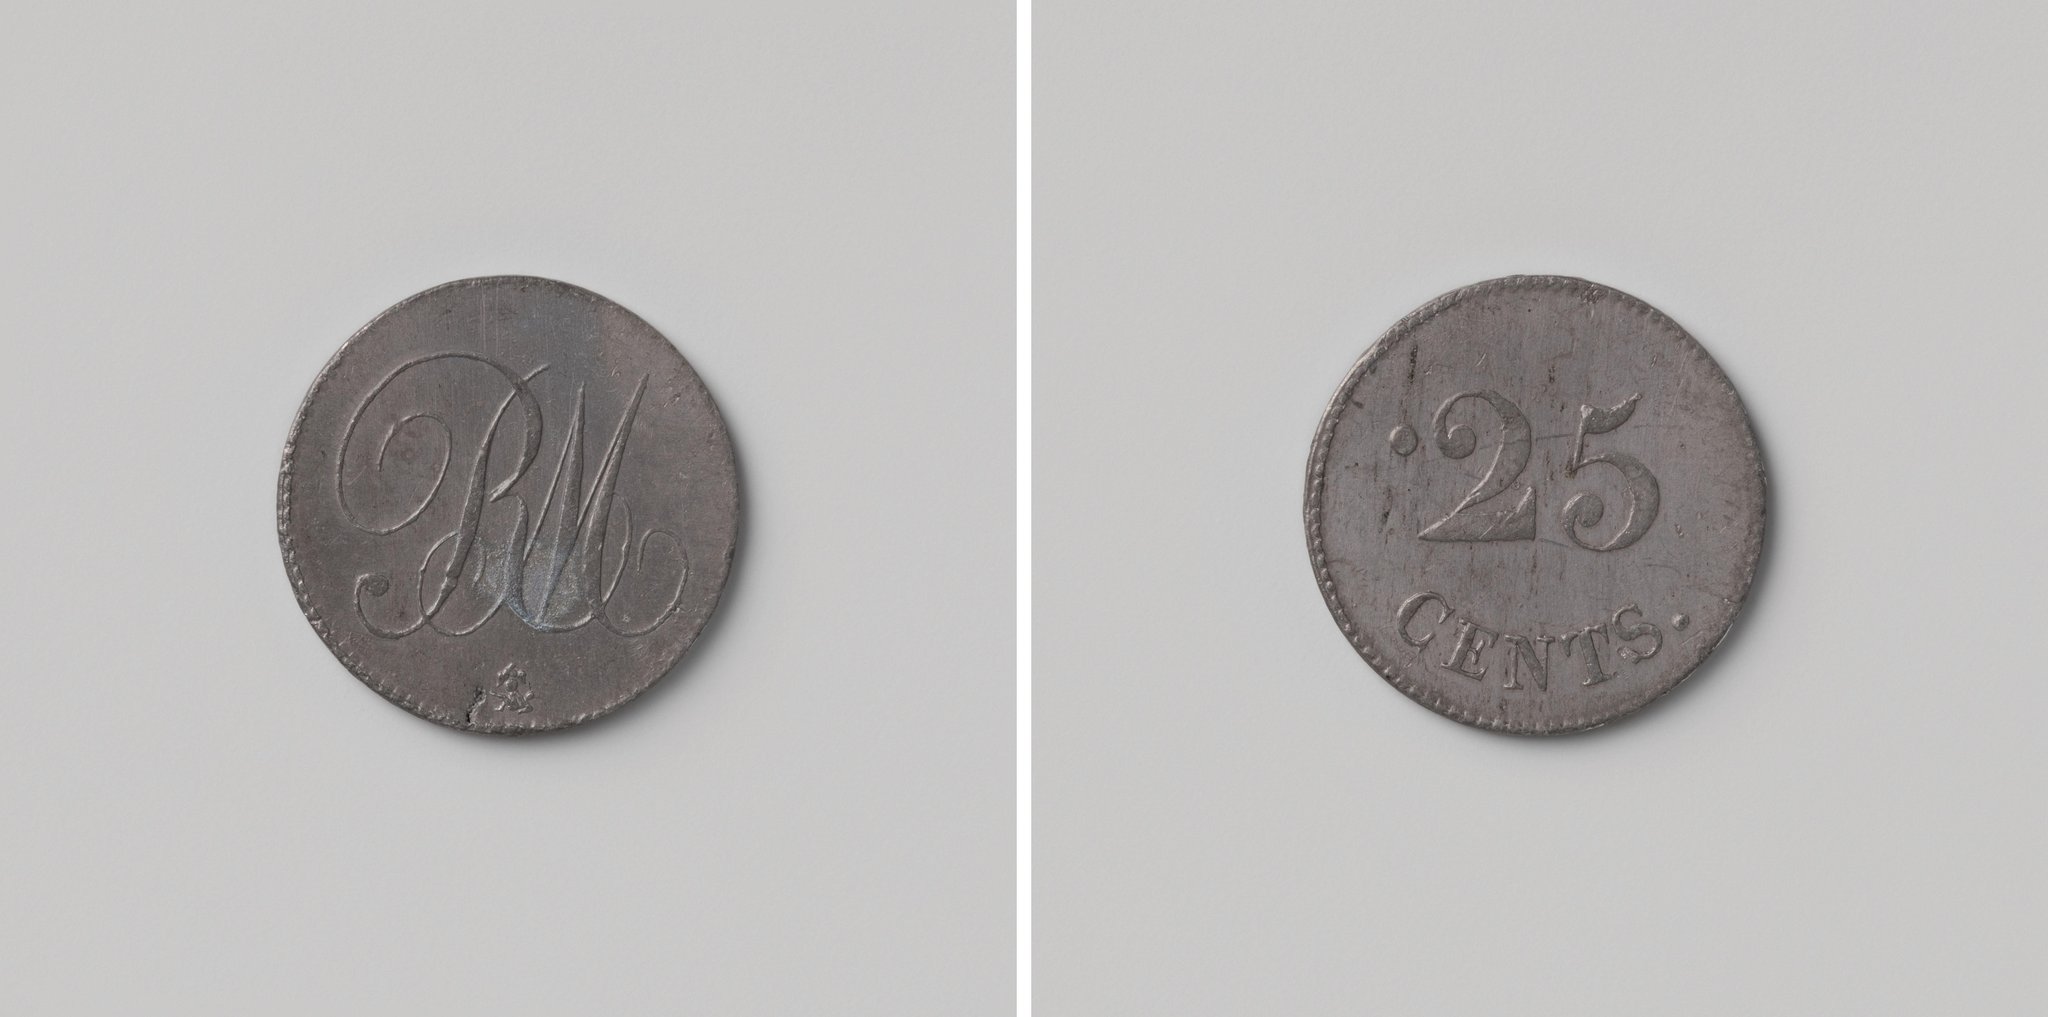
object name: medal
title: Huismunt van de kolonies Rijkevorsel en Merksplas ter waarde van 25 cent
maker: Anonymous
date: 1823-1839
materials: zinc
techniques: striking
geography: brussels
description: Zinken munt. Voorzijde: monogram van letters R en M boven merktekentje. Keerzijde: waardeaanduiding